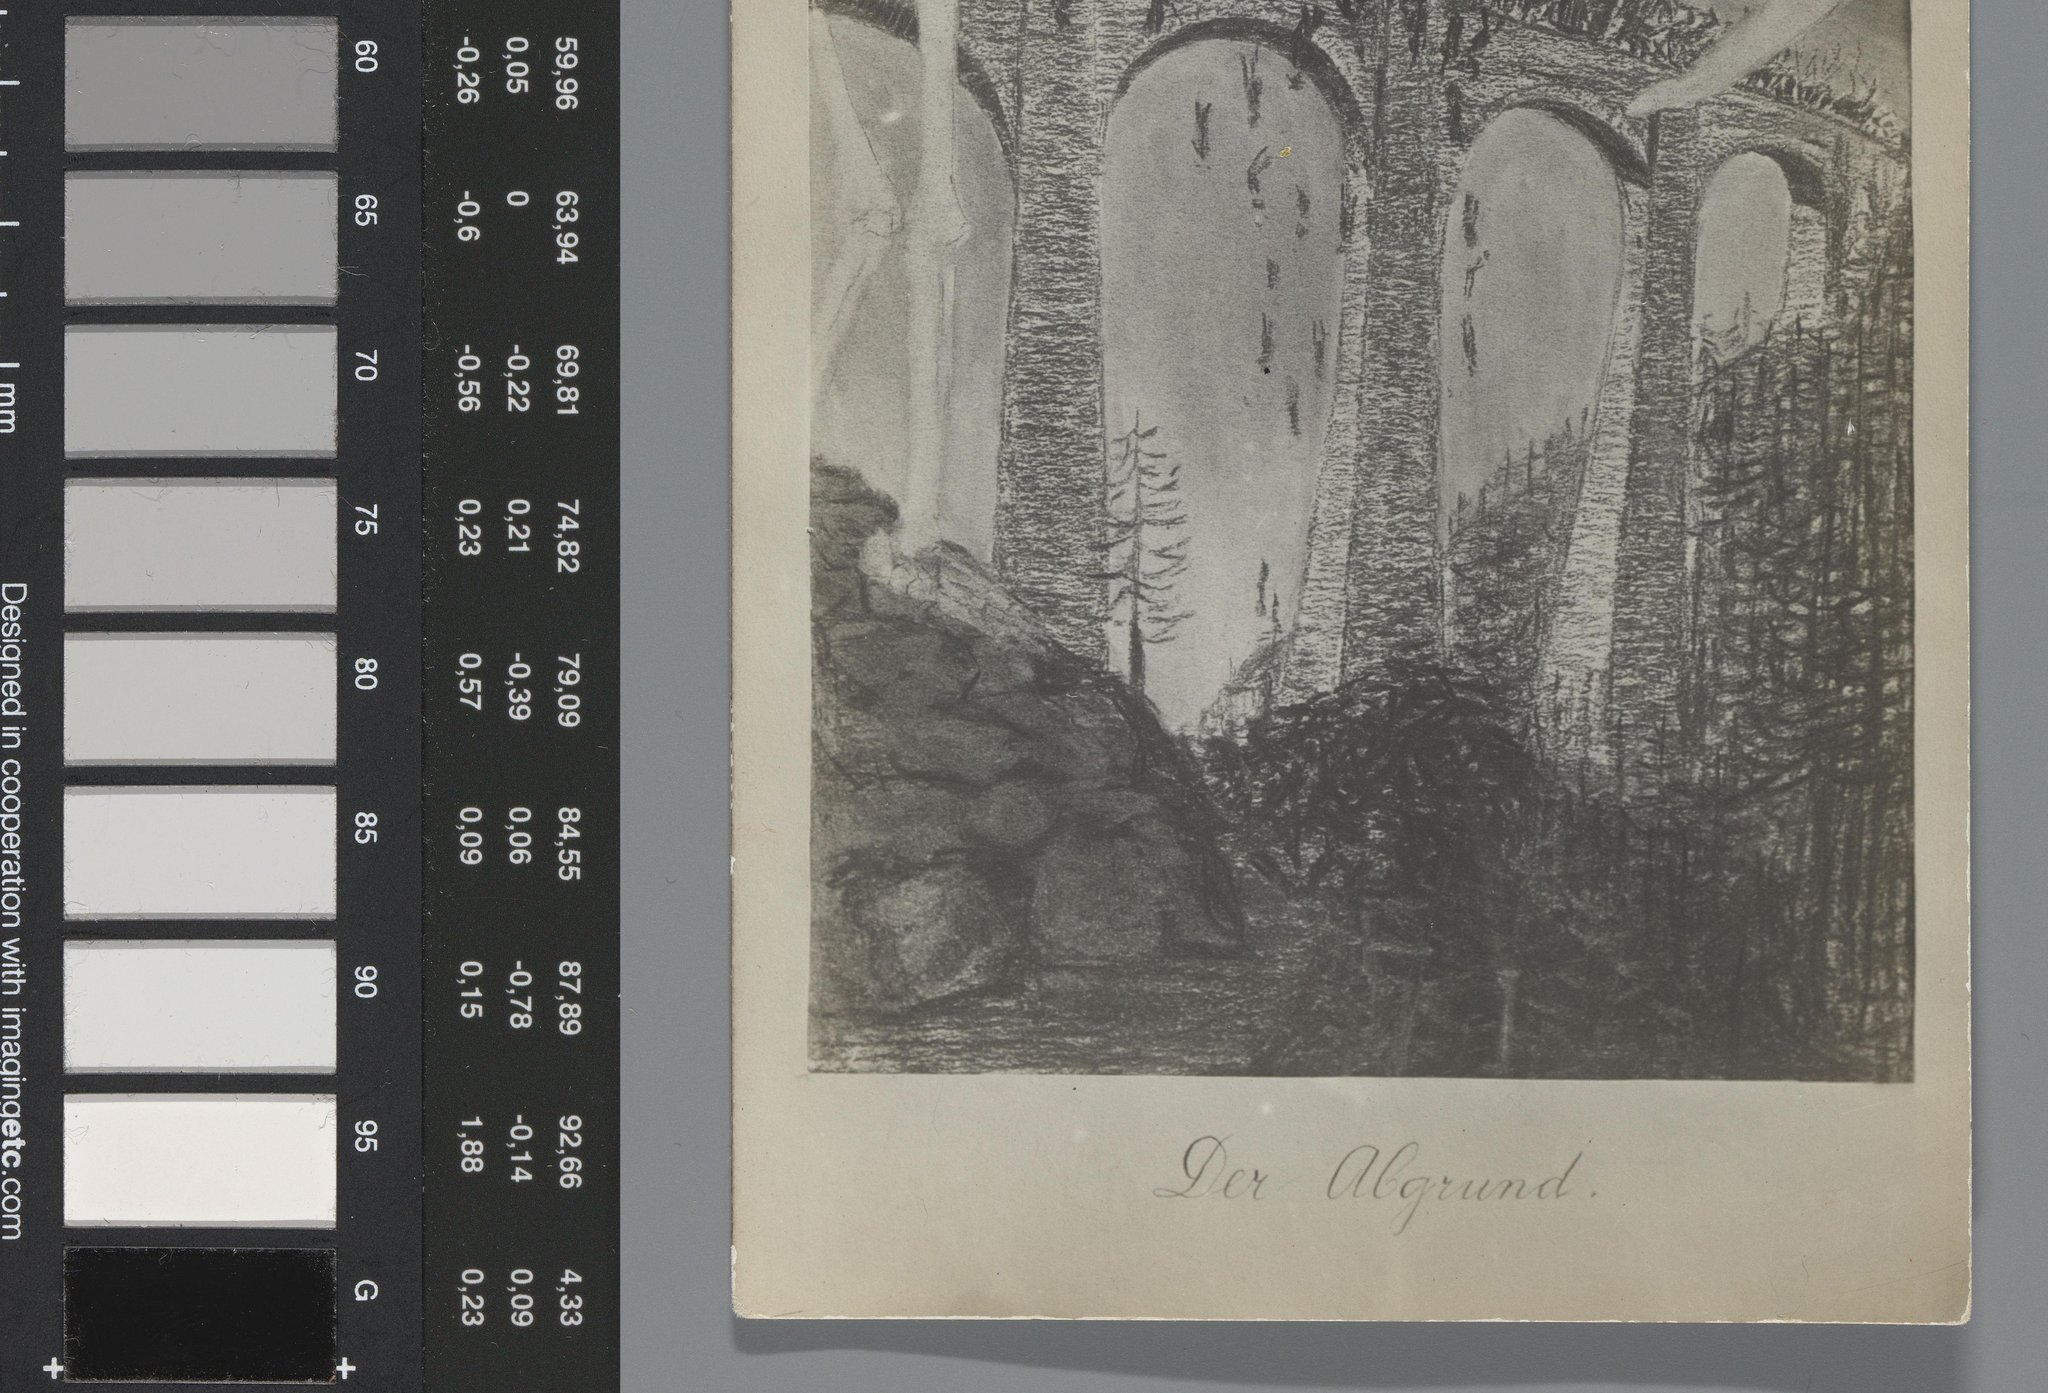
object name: photograph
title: Der Abgrund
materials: paper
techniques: gelatin silver print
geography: amsterdam